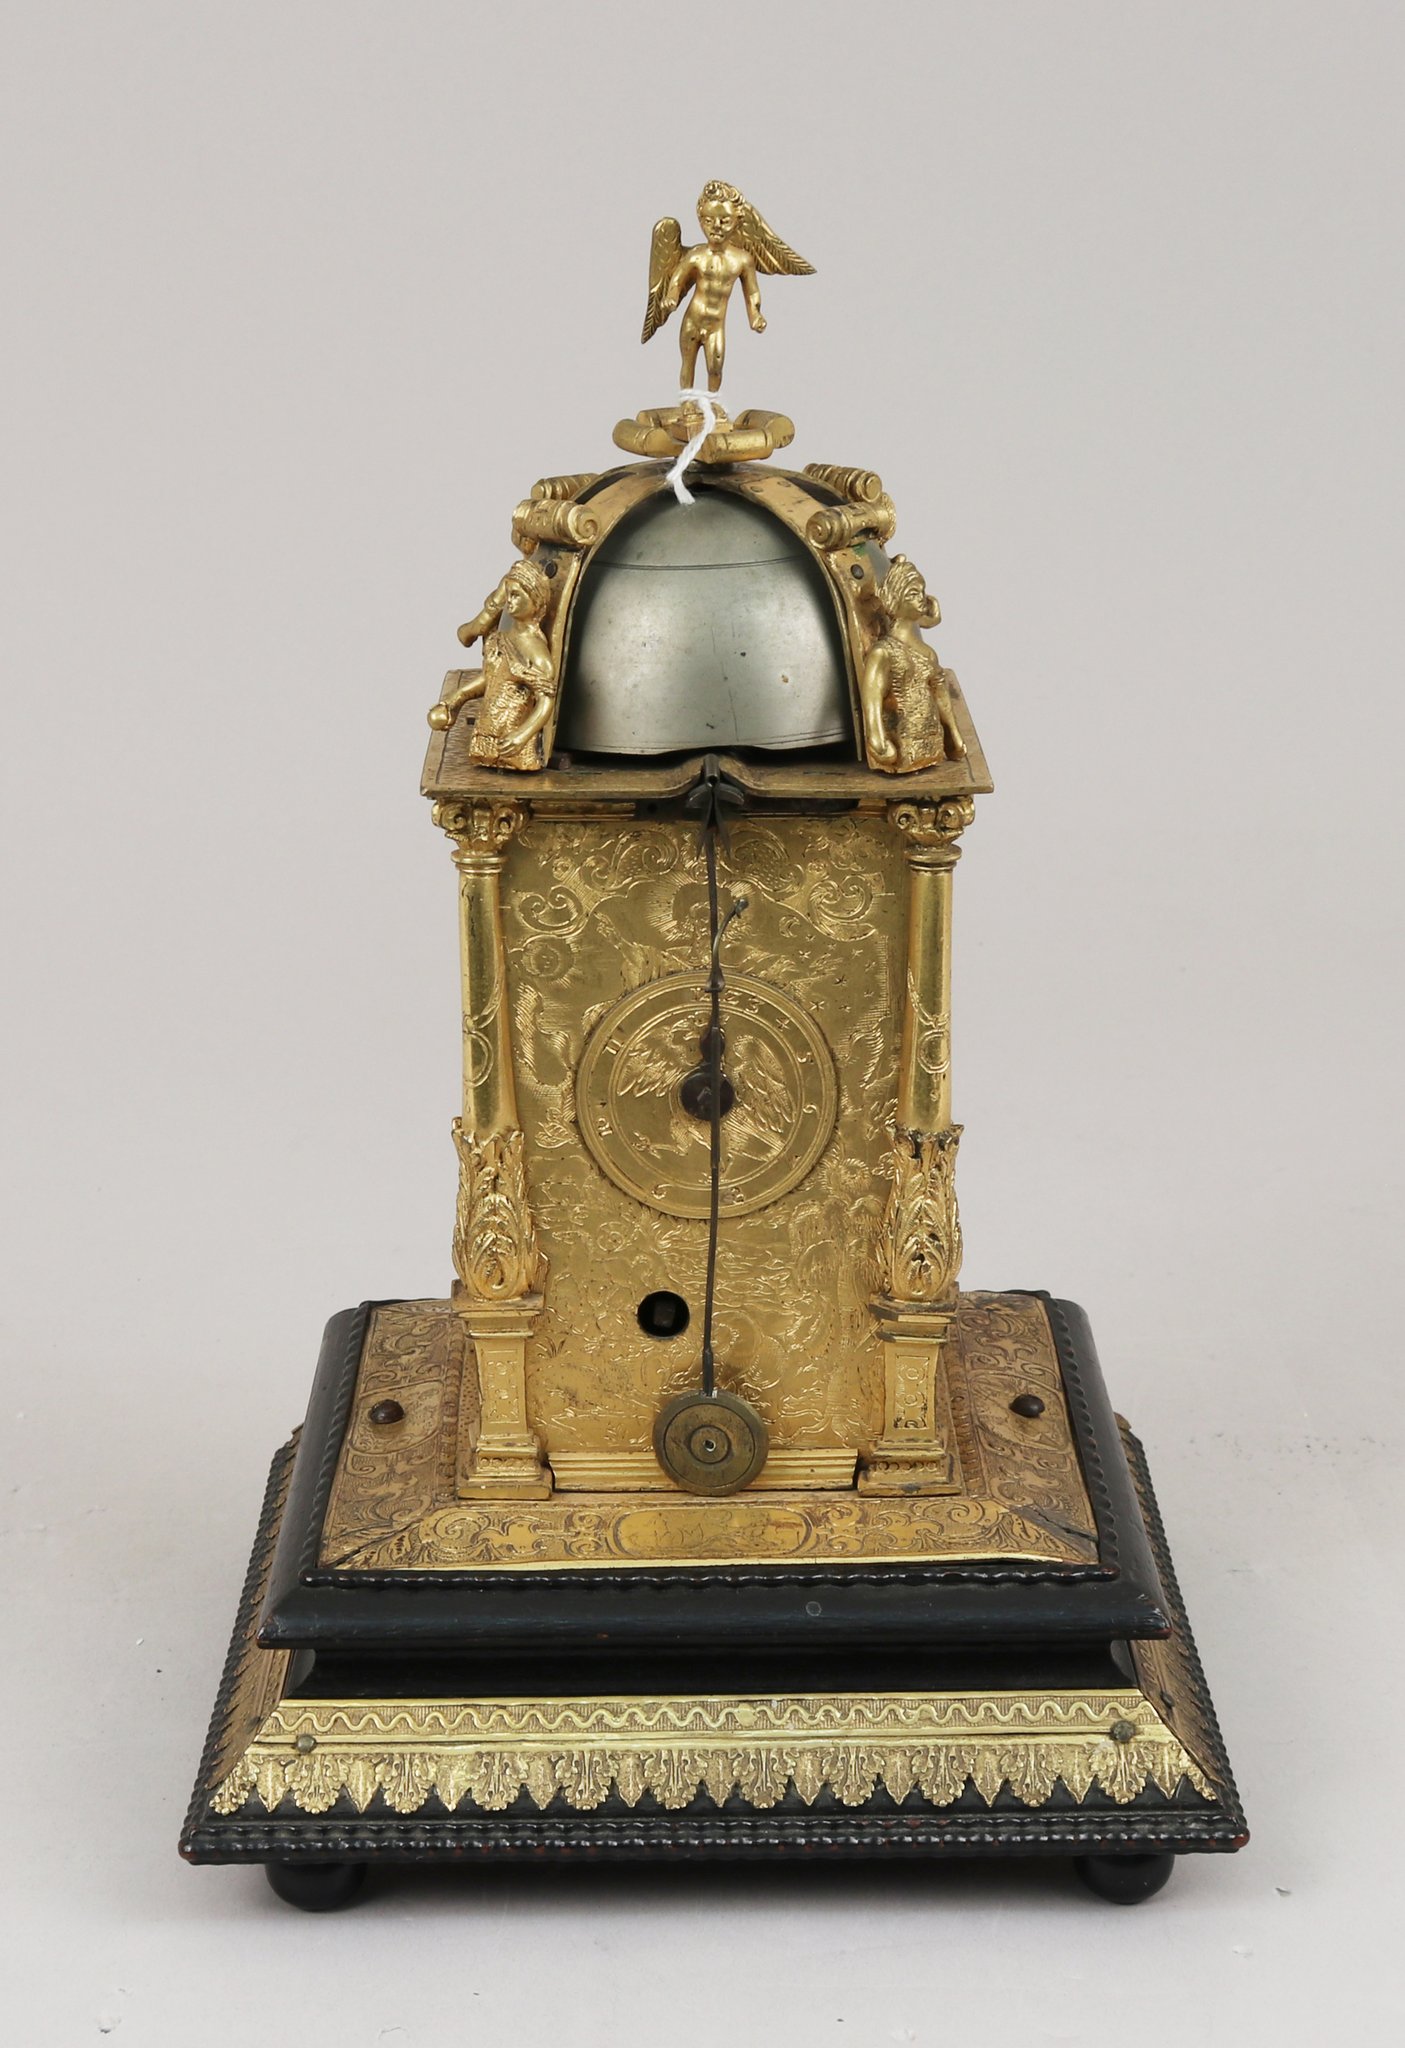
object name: clock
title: Tower Clock with scenes of the Creation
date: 1601-1700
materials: brass, wood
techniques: gilding, silvered